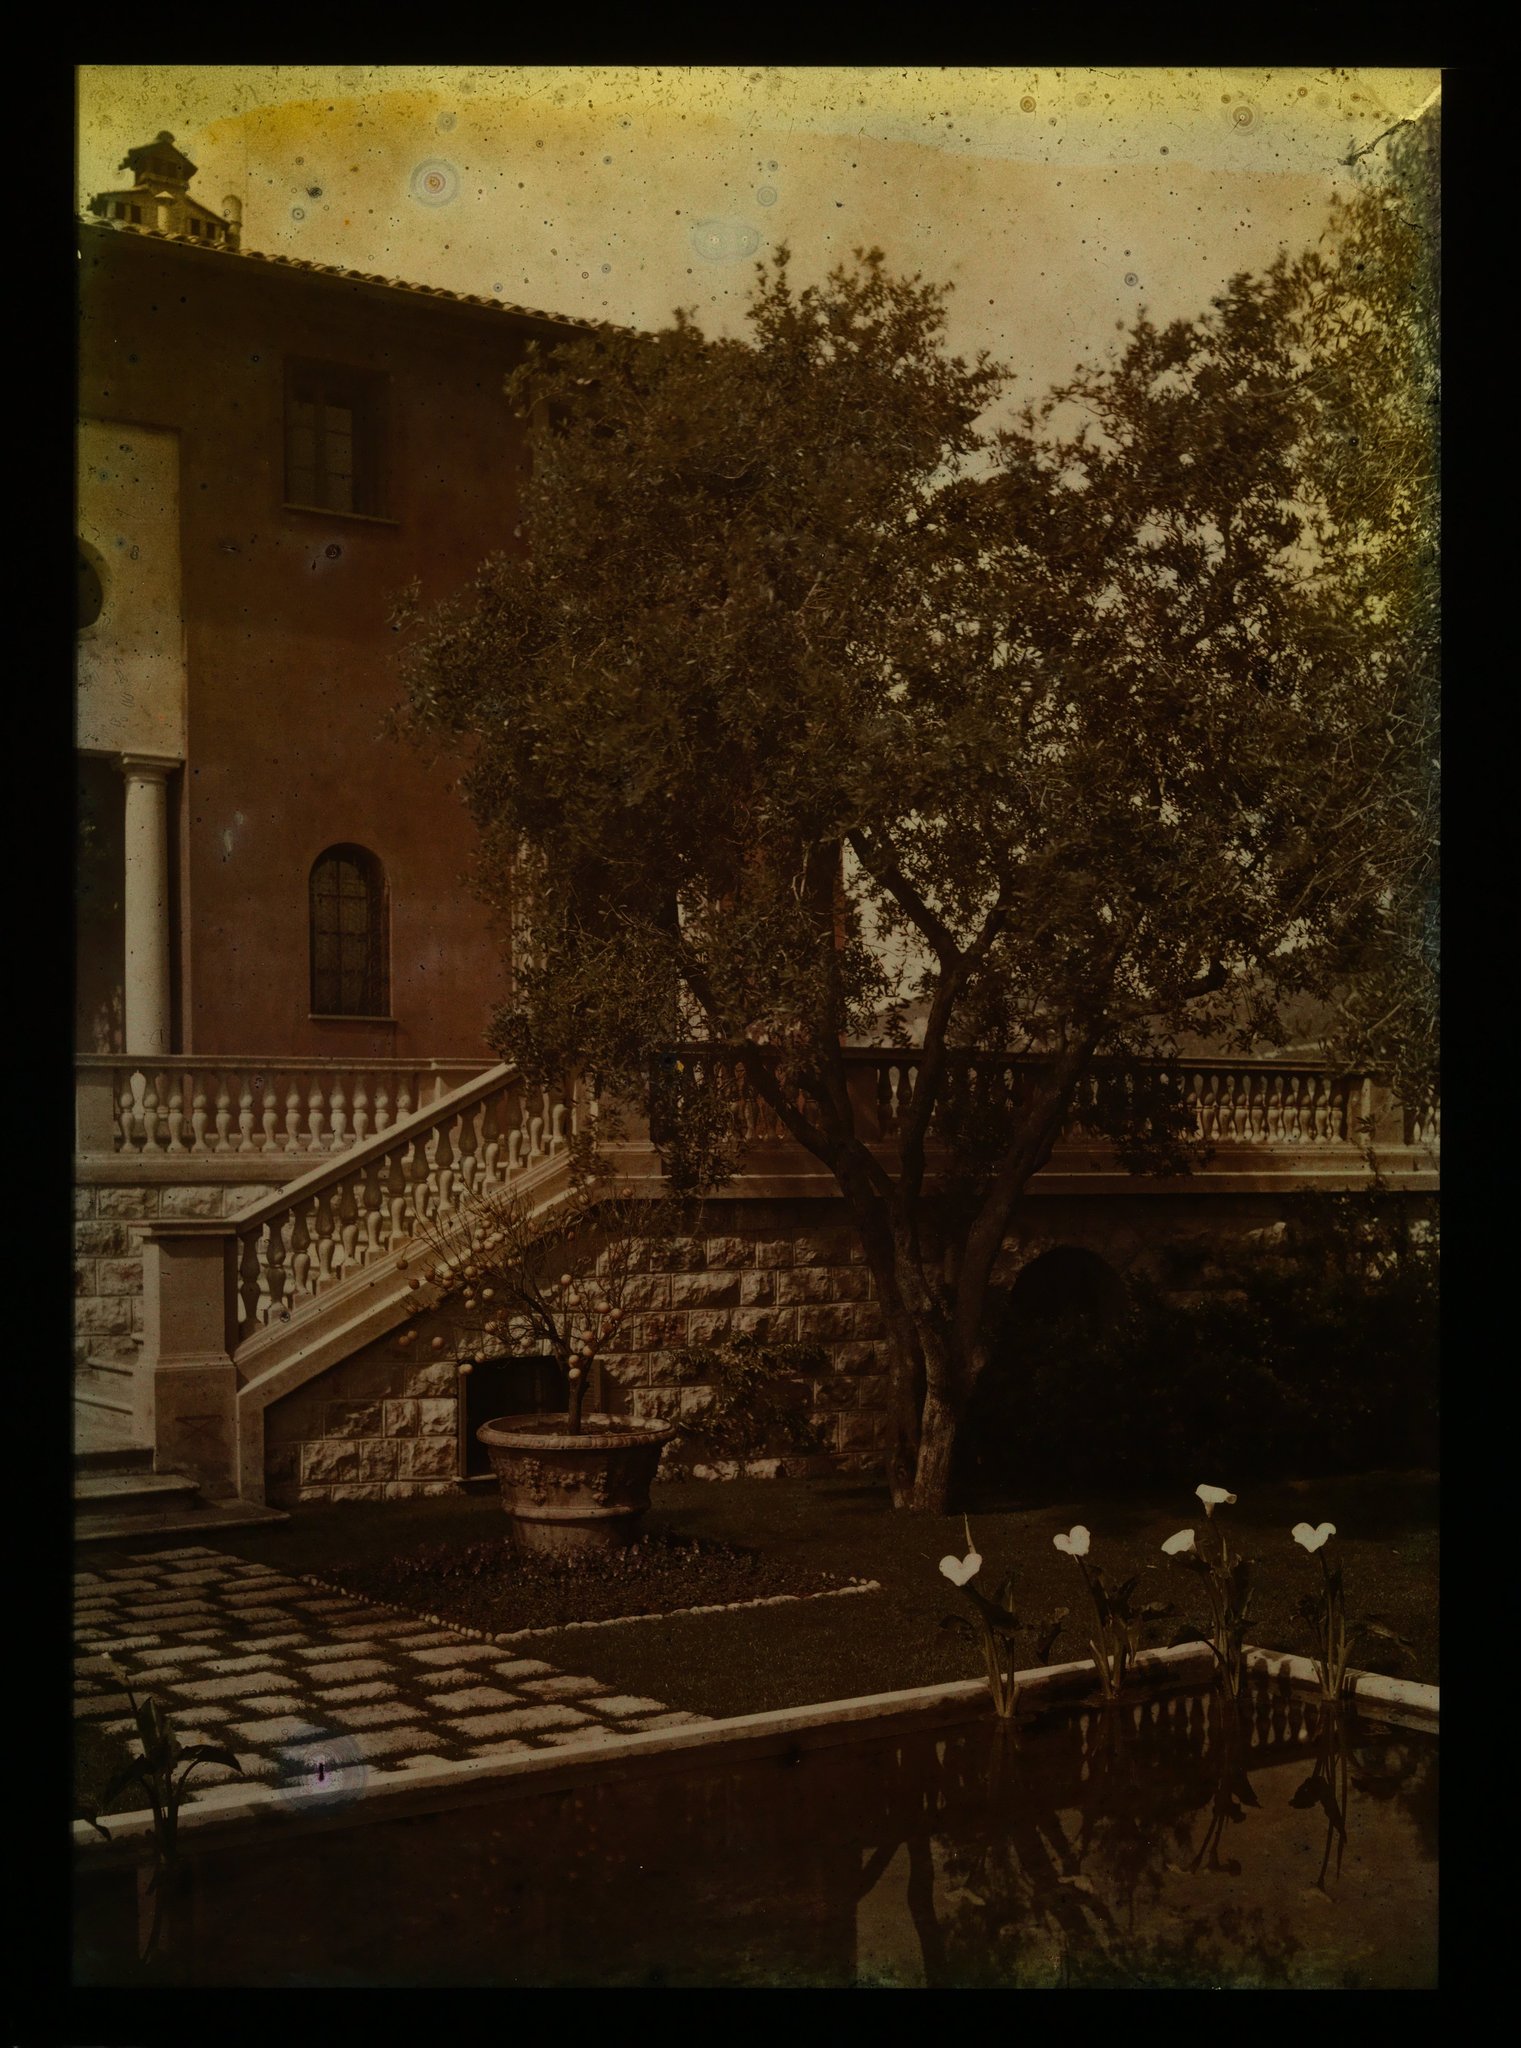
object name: photograph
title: Roze gepleisterd huis met tuin met vijver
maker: Anonymous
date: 1910-1940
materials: glass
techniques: autochrome process